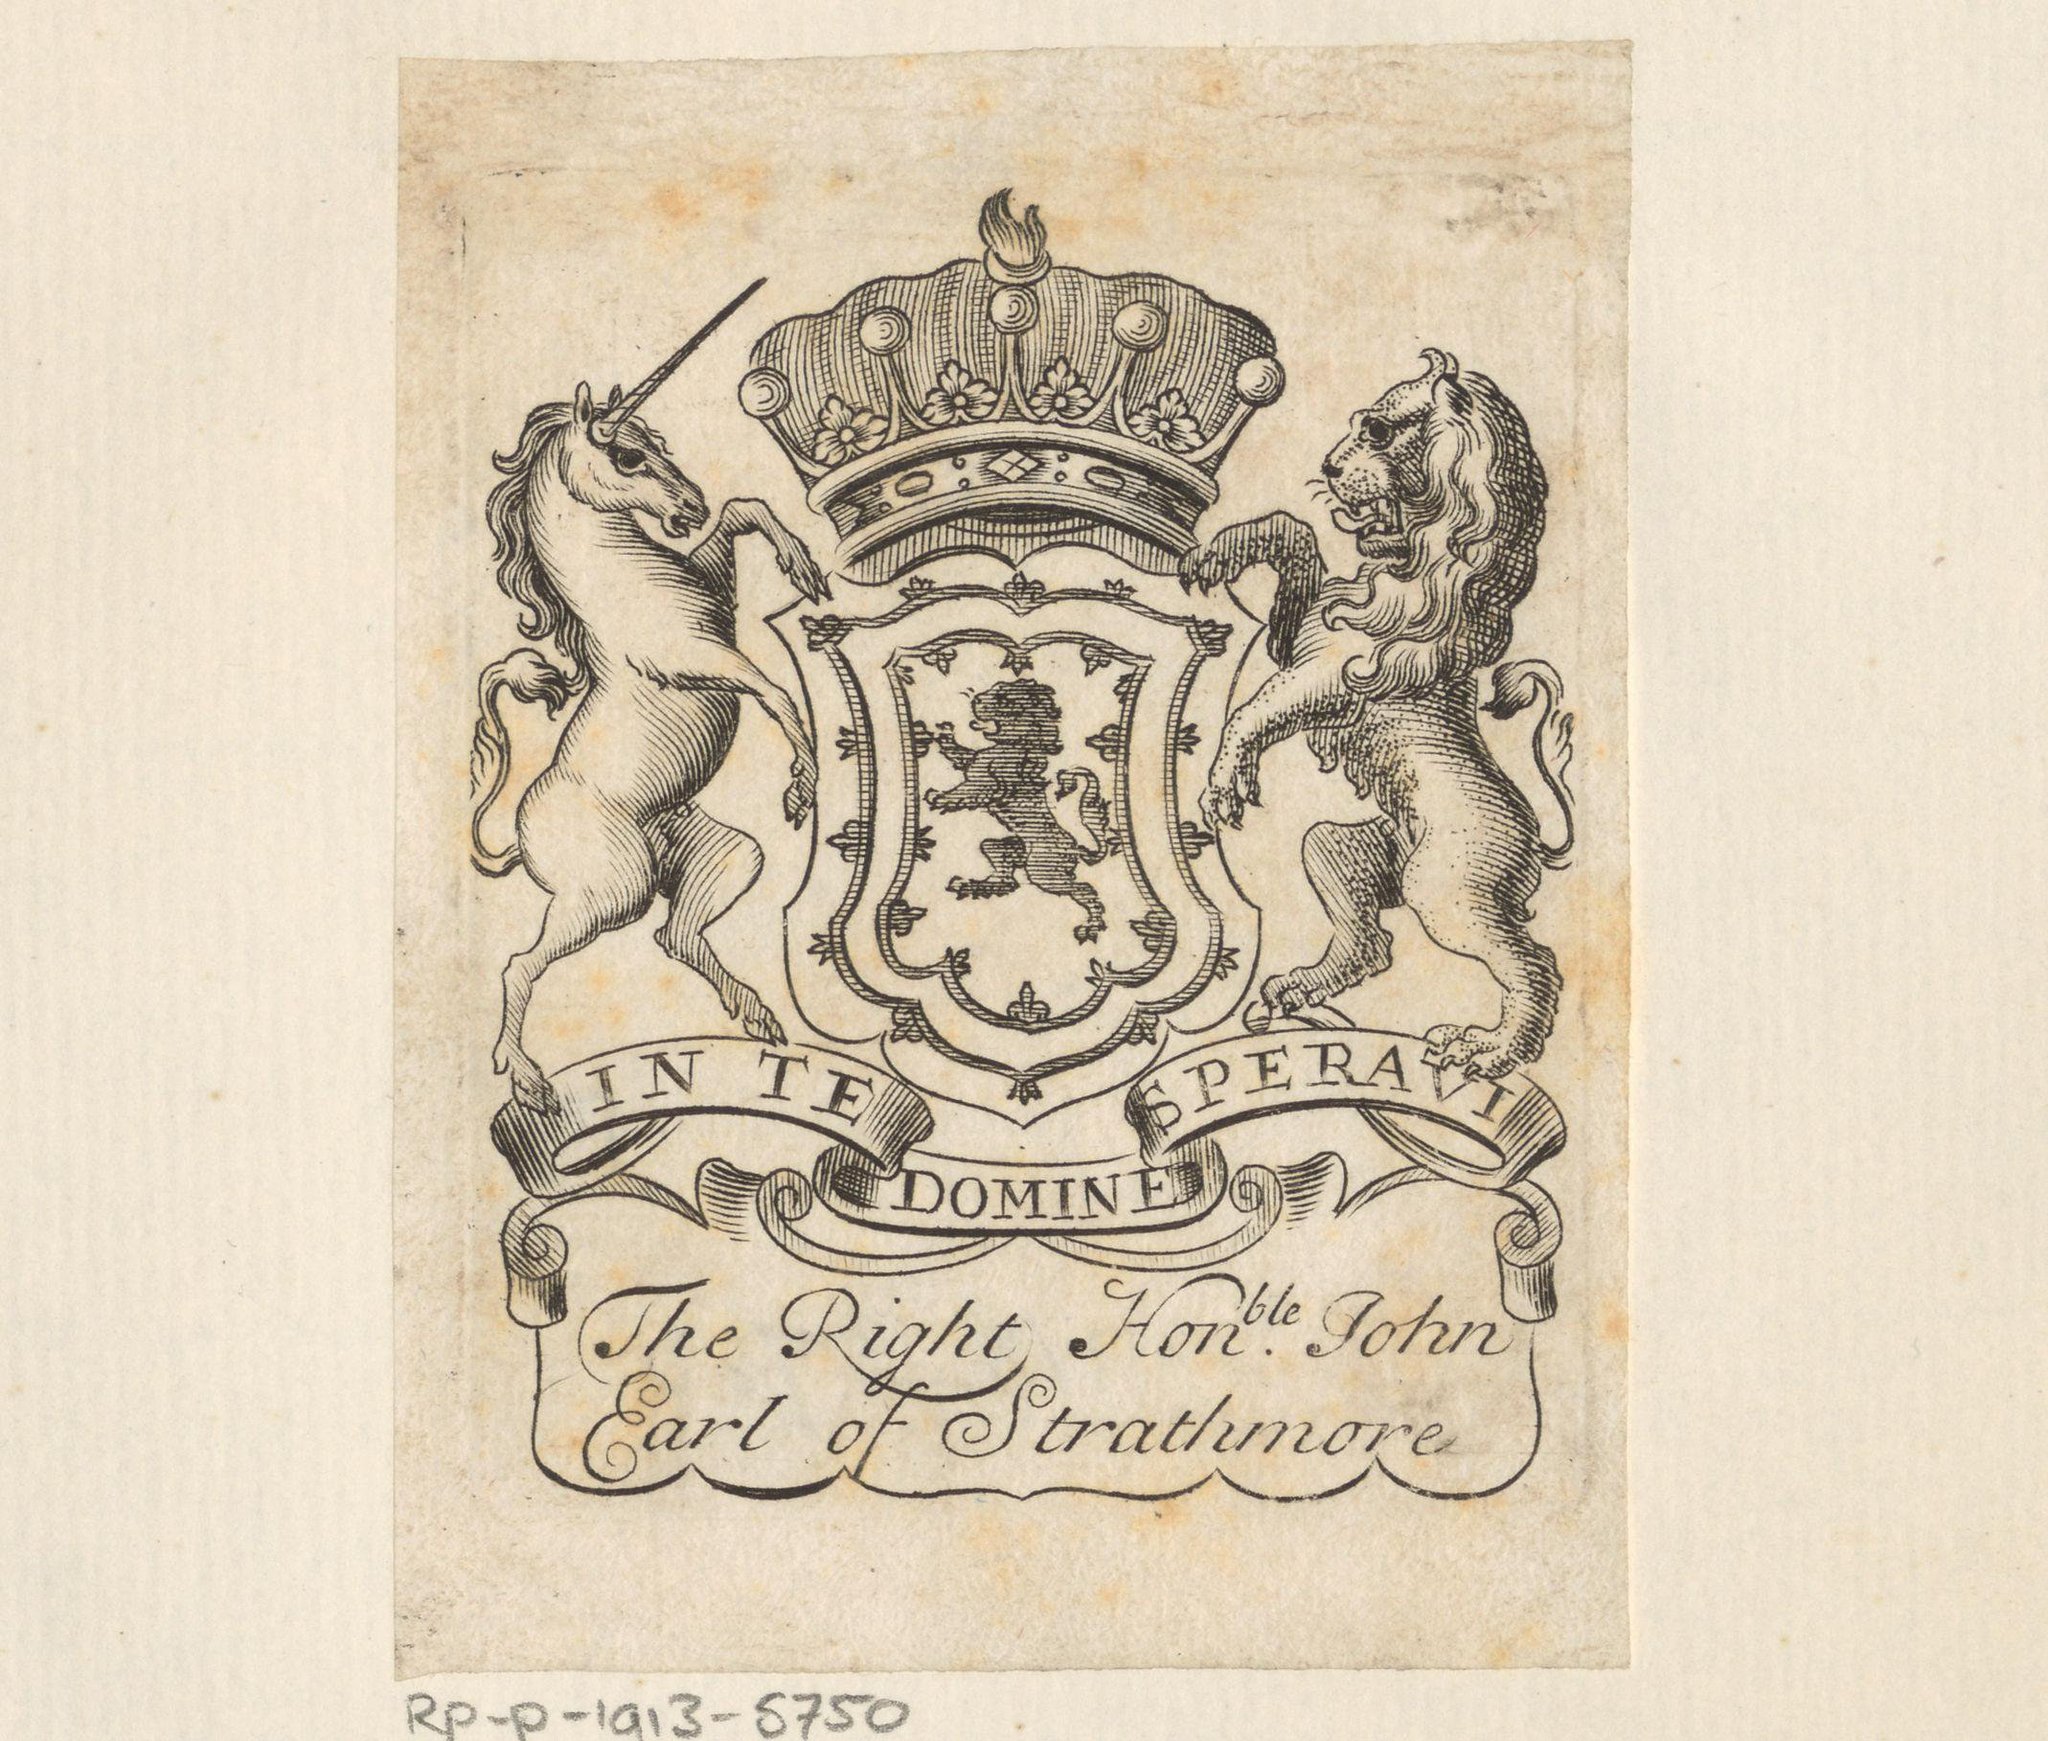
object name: bookplate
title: In te domine speravi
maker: Anonymous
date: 1650-1799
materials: paper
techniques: engraving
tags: armorial bearing, heraldry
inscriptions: collector's mark: Lugt 2233, collector's mark: Lugt 2760